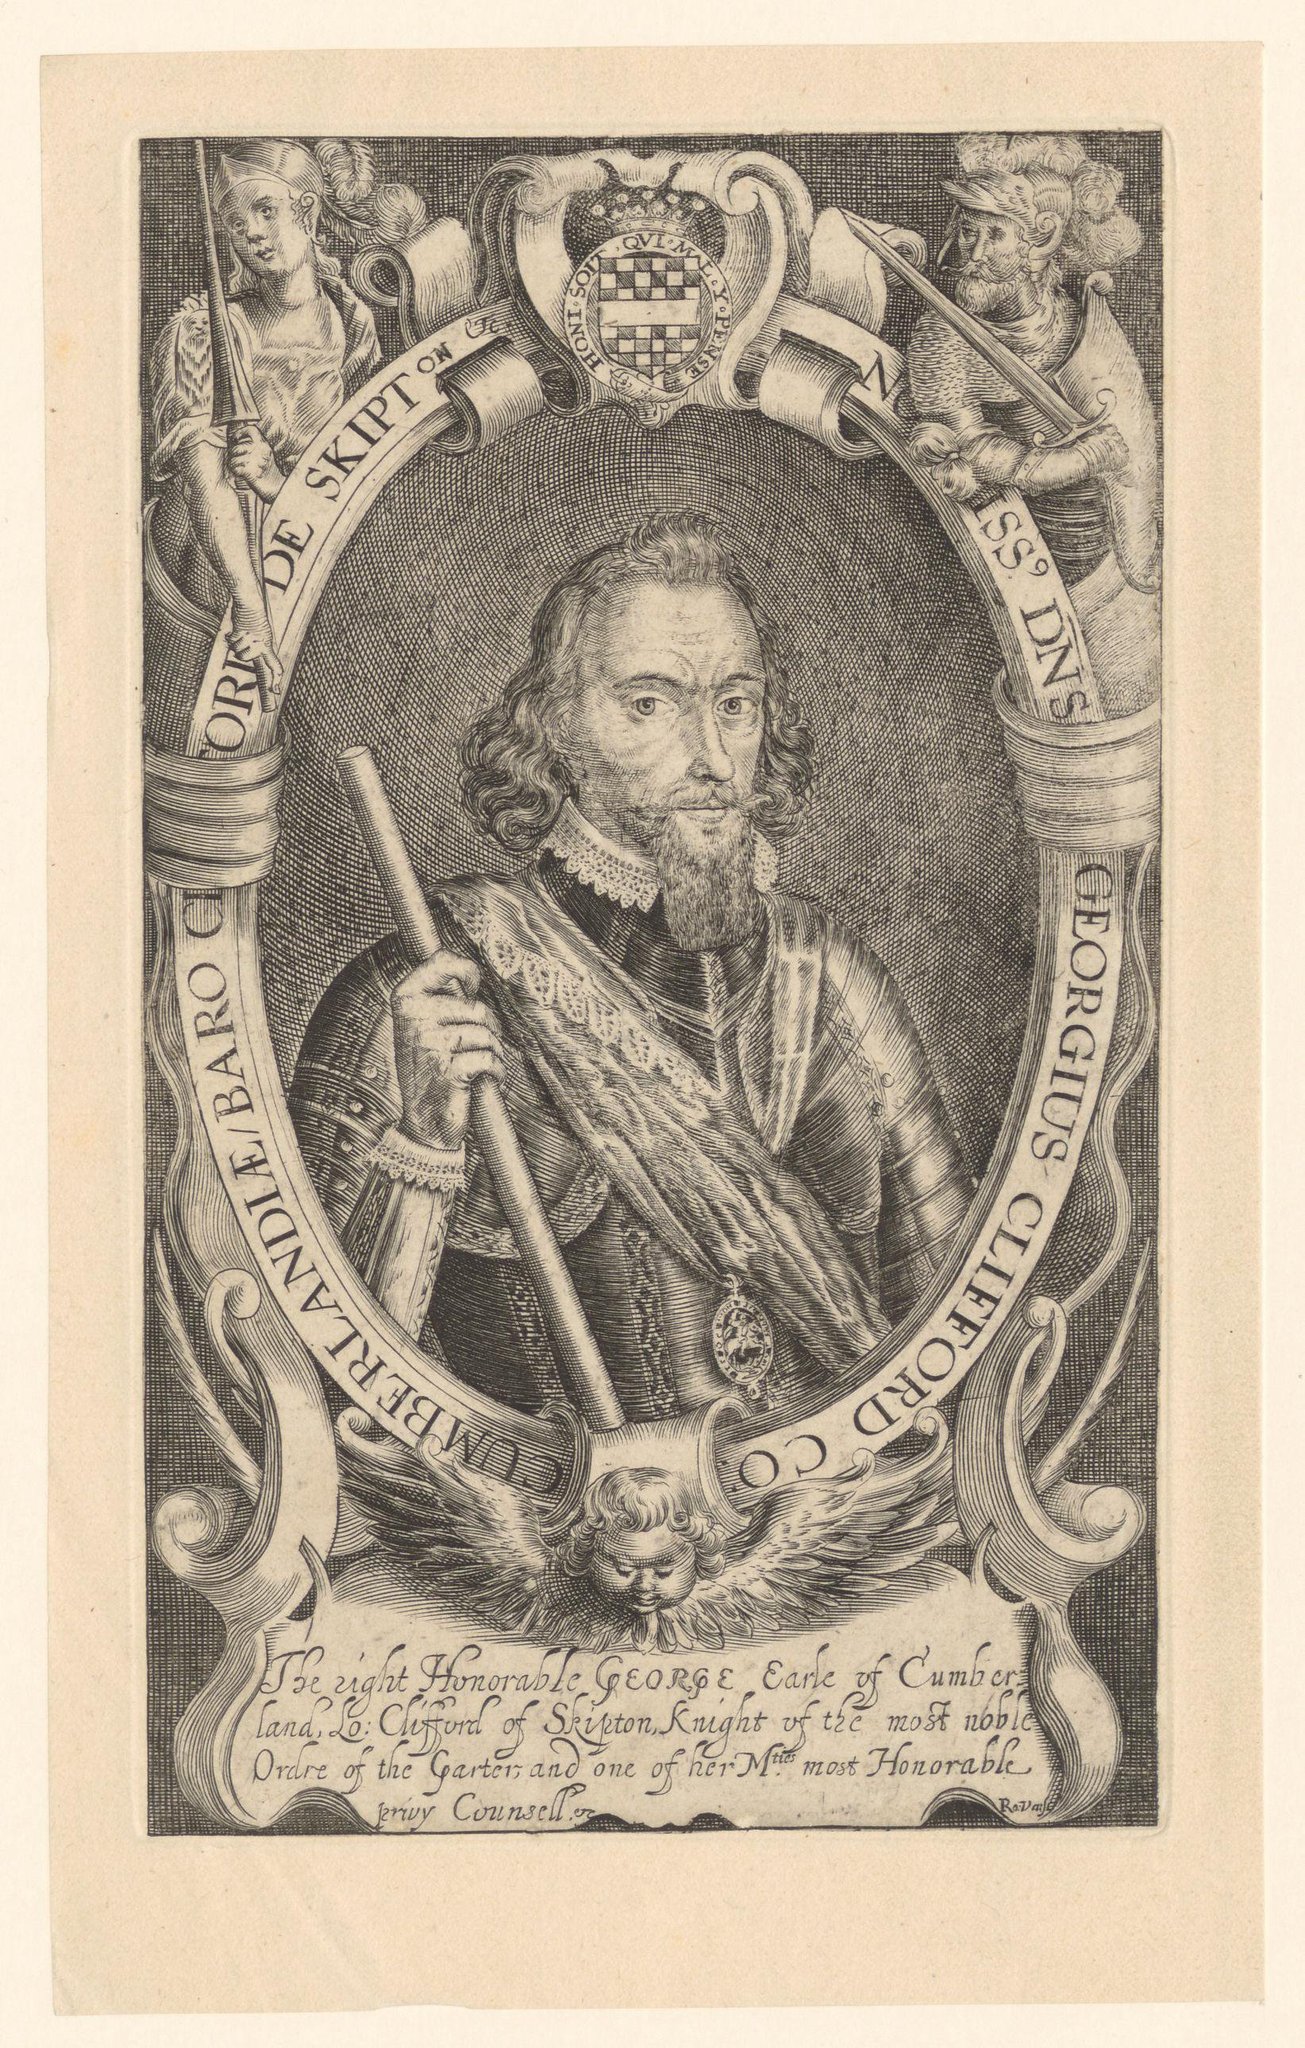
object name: print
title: Portret van George Clifford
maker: robert vaughan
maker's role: print maker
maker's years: 1600-1660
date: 1610-1660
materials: paper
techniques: engraving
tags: commander-in-chief, general, marshal, historical persons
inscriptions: collector's mark: Lugt 2228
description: Tekst in het Engels in de omlijsting en in de cartouche.